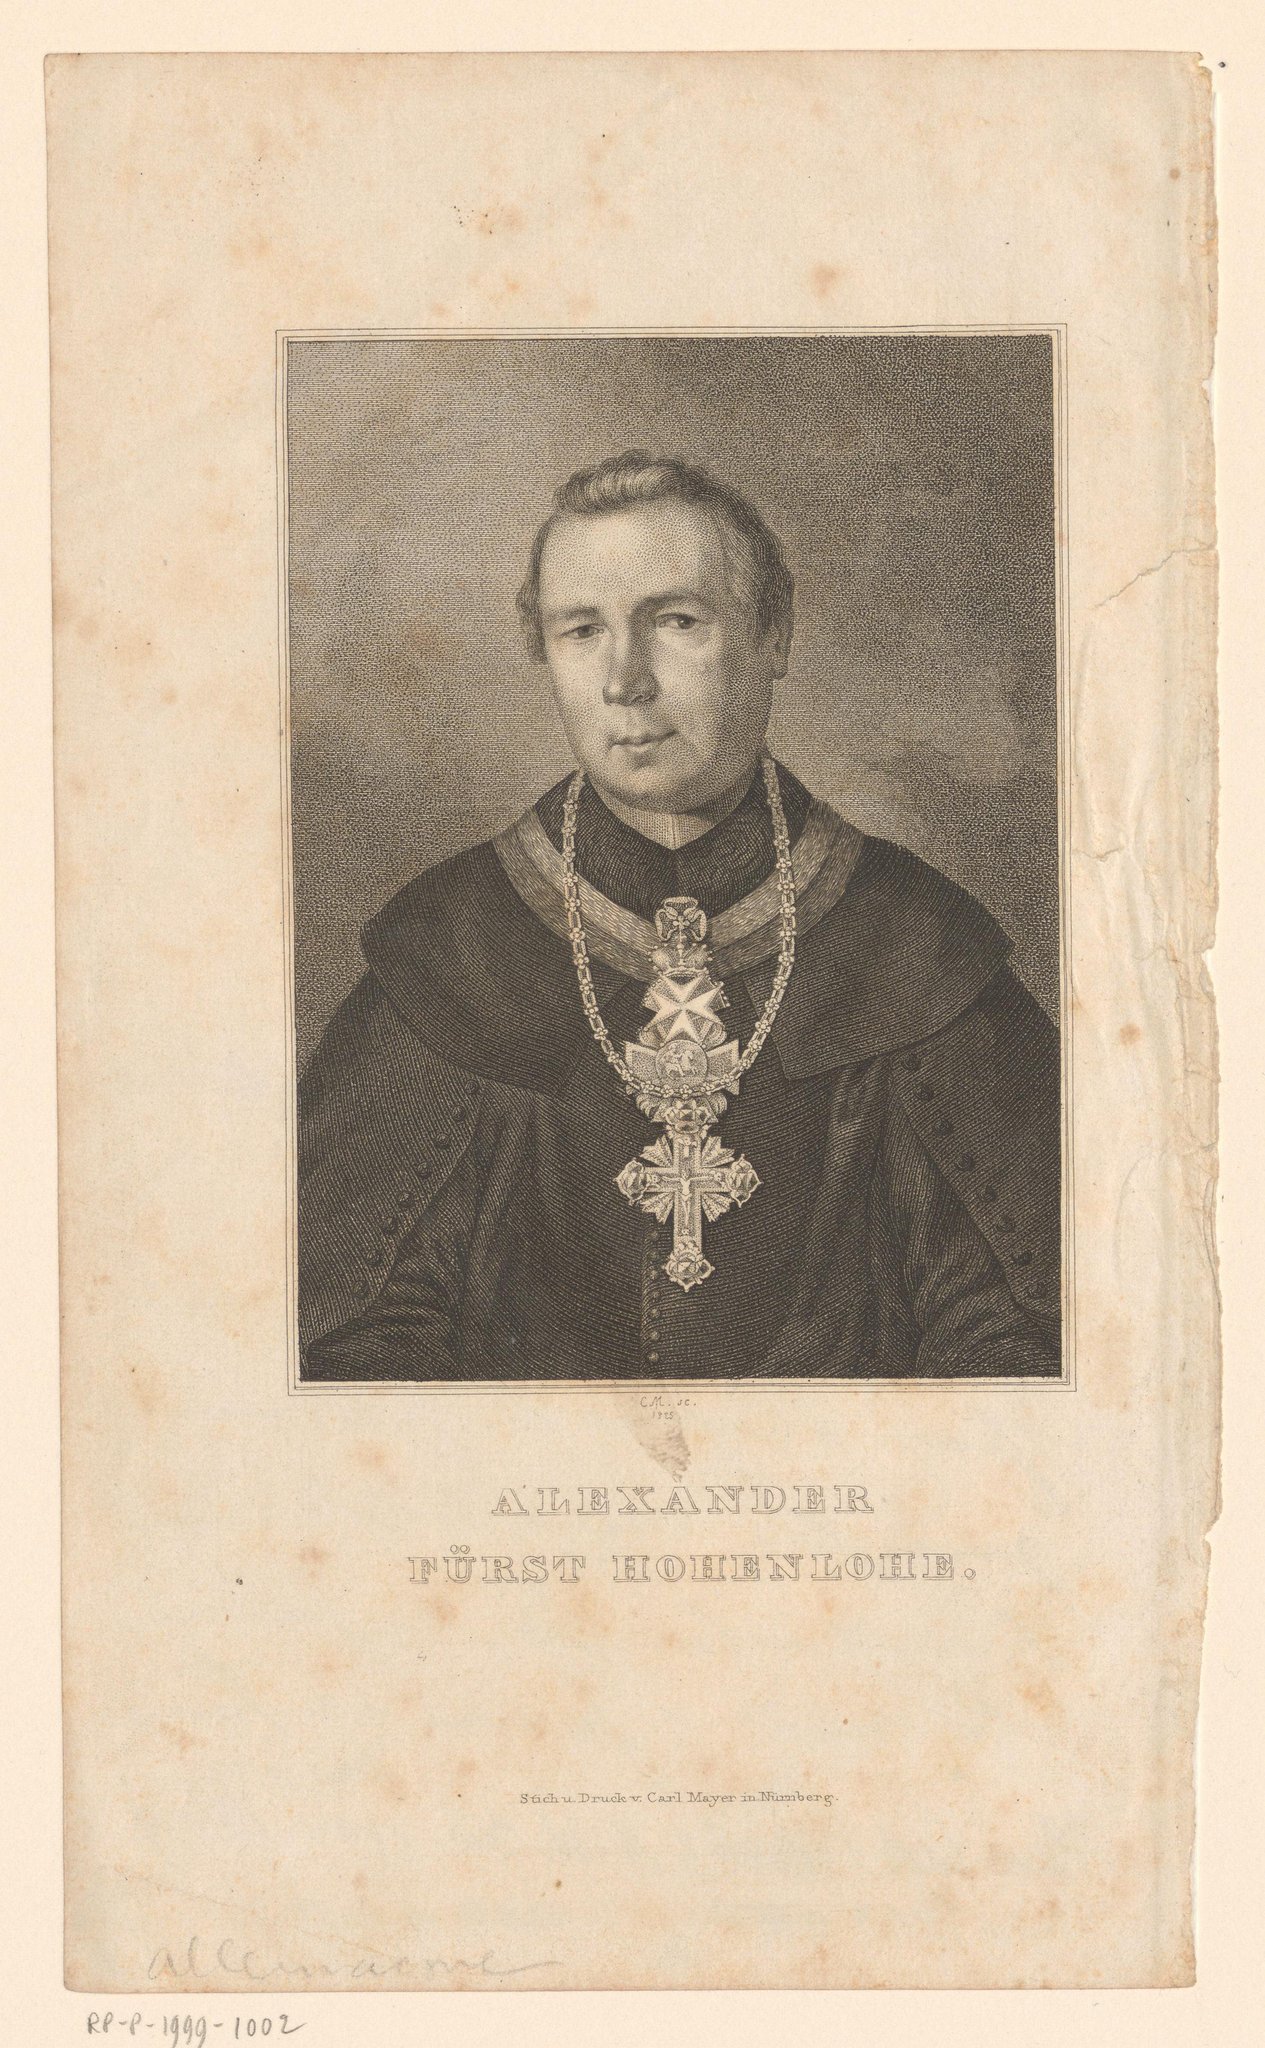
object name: print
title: Portret van Alexander zu Hohenlohe-Waldenburg-Schillingsfürst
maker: carl mayer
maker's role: print maker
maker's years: 1798-1868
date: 1835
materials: paper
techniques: engraving, etching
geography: nuremberg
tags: priest (roman catholic), adult man, historical persons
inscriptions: inscription, collector's mark: Lugt 2760, collector's mark: Lugt 2228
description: Alexander Fürst von Hohenlohe (1794-1849), werd in 1815 tot priester gewijd. In 1816 toegetreden tot de Johannieterorde. Portret ten halve lijve, van voren gezien, in priesterkleding, met groot Johannieterkruis op de borst.